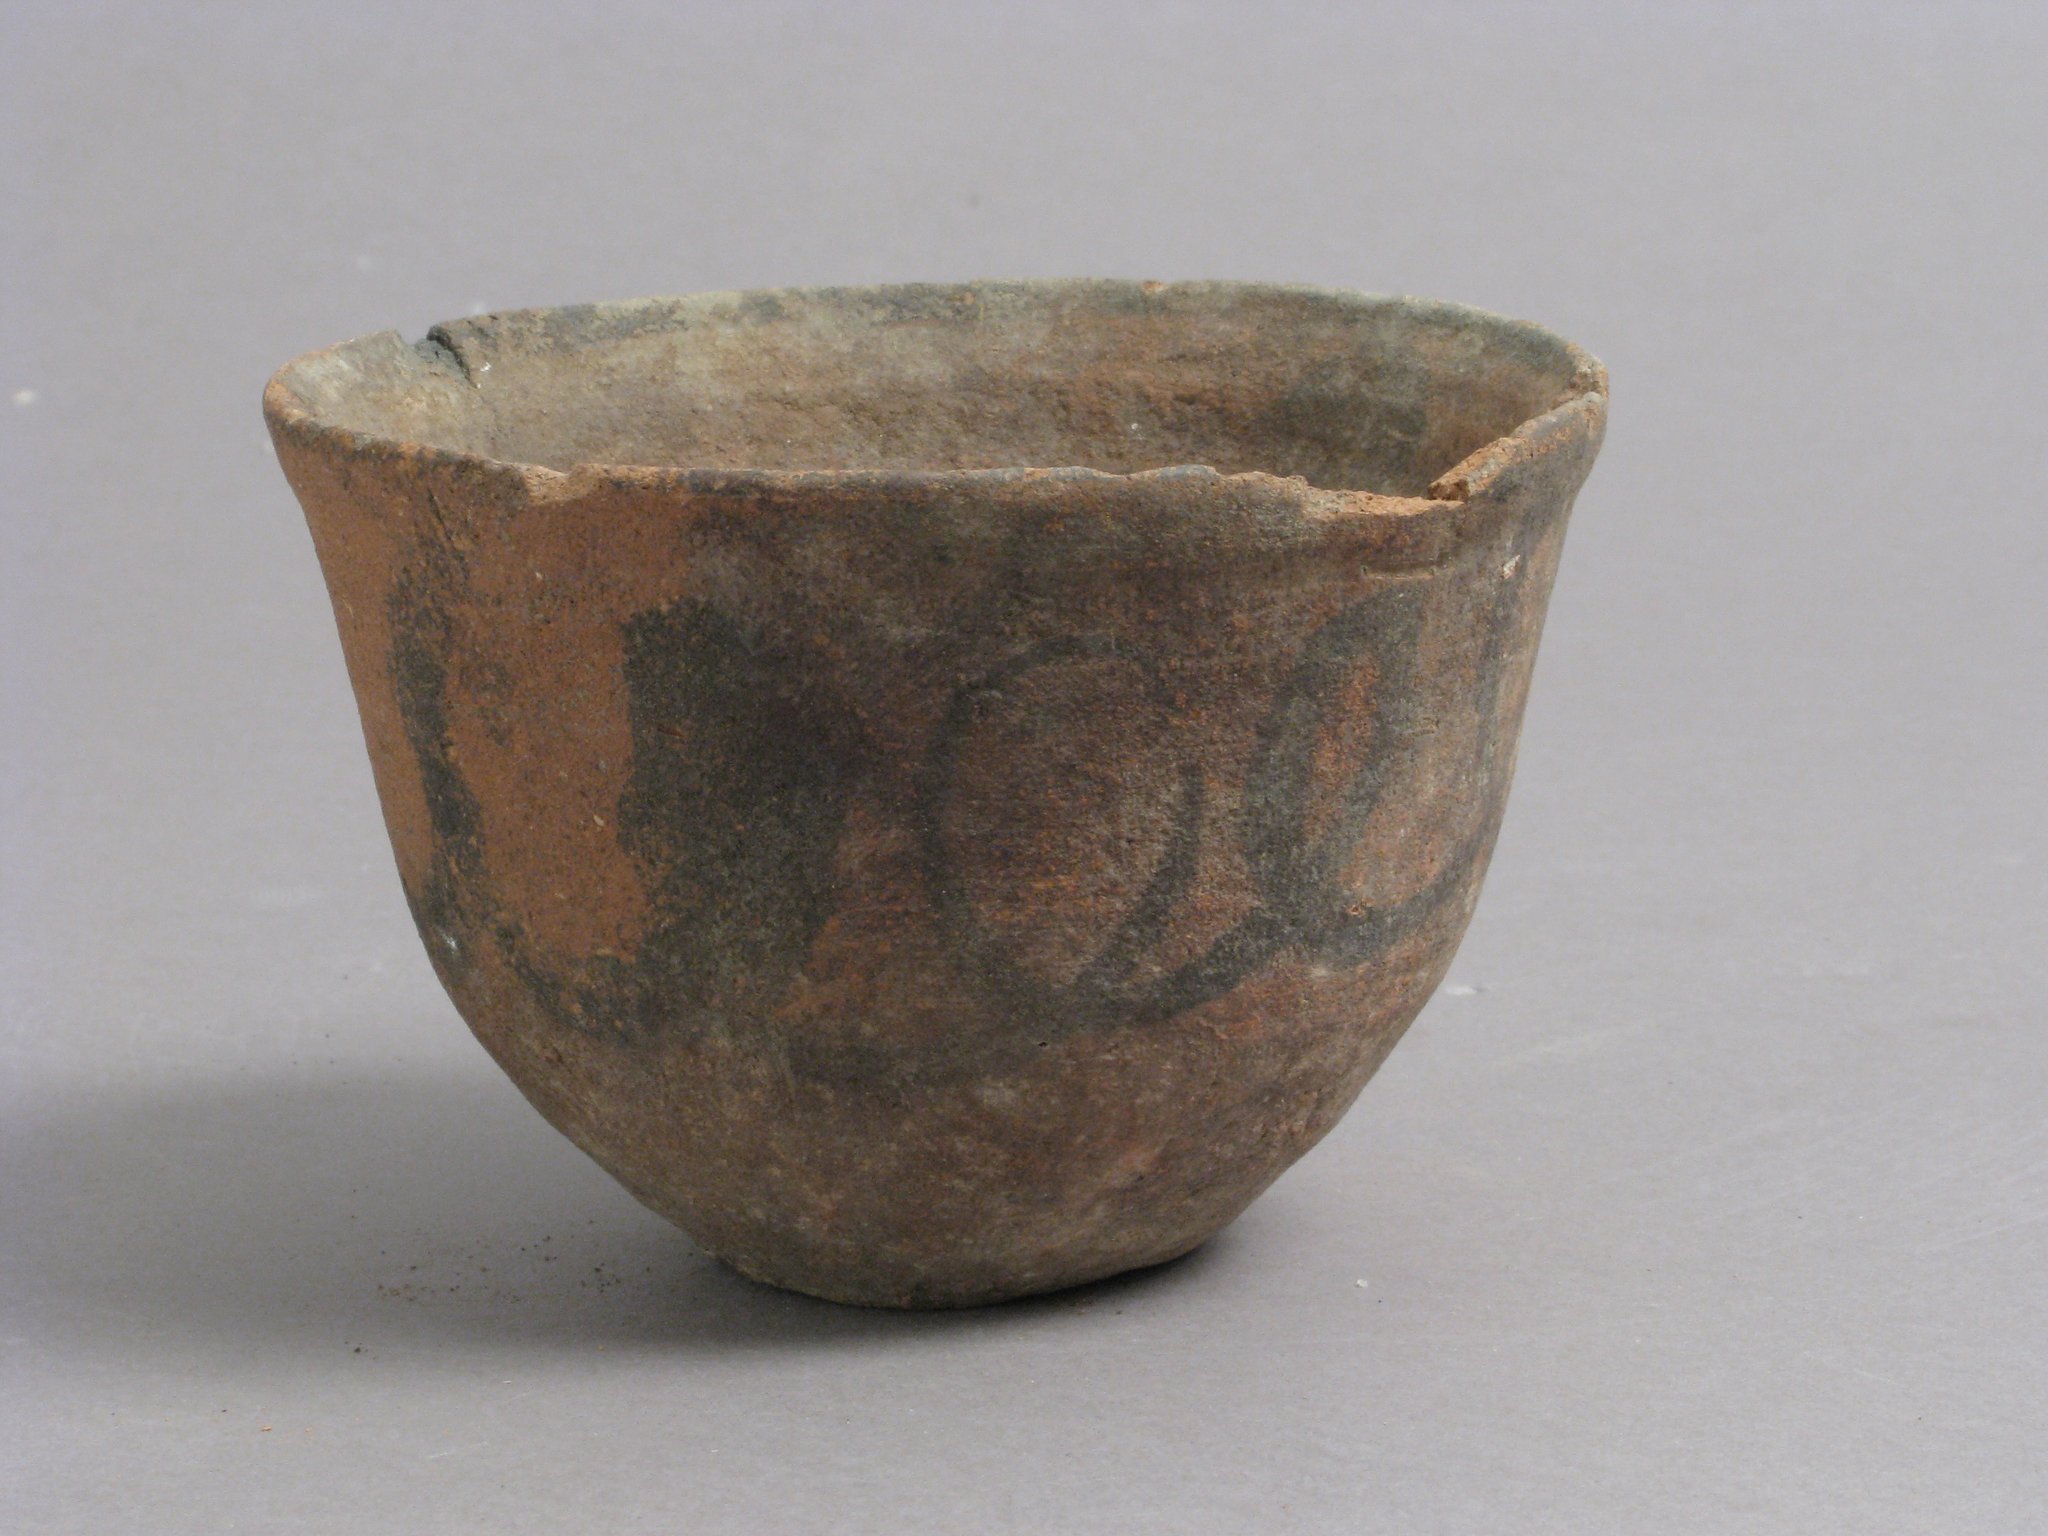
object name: bowl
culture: coptic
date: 301-700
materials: earthenware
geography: egypt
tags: bowls